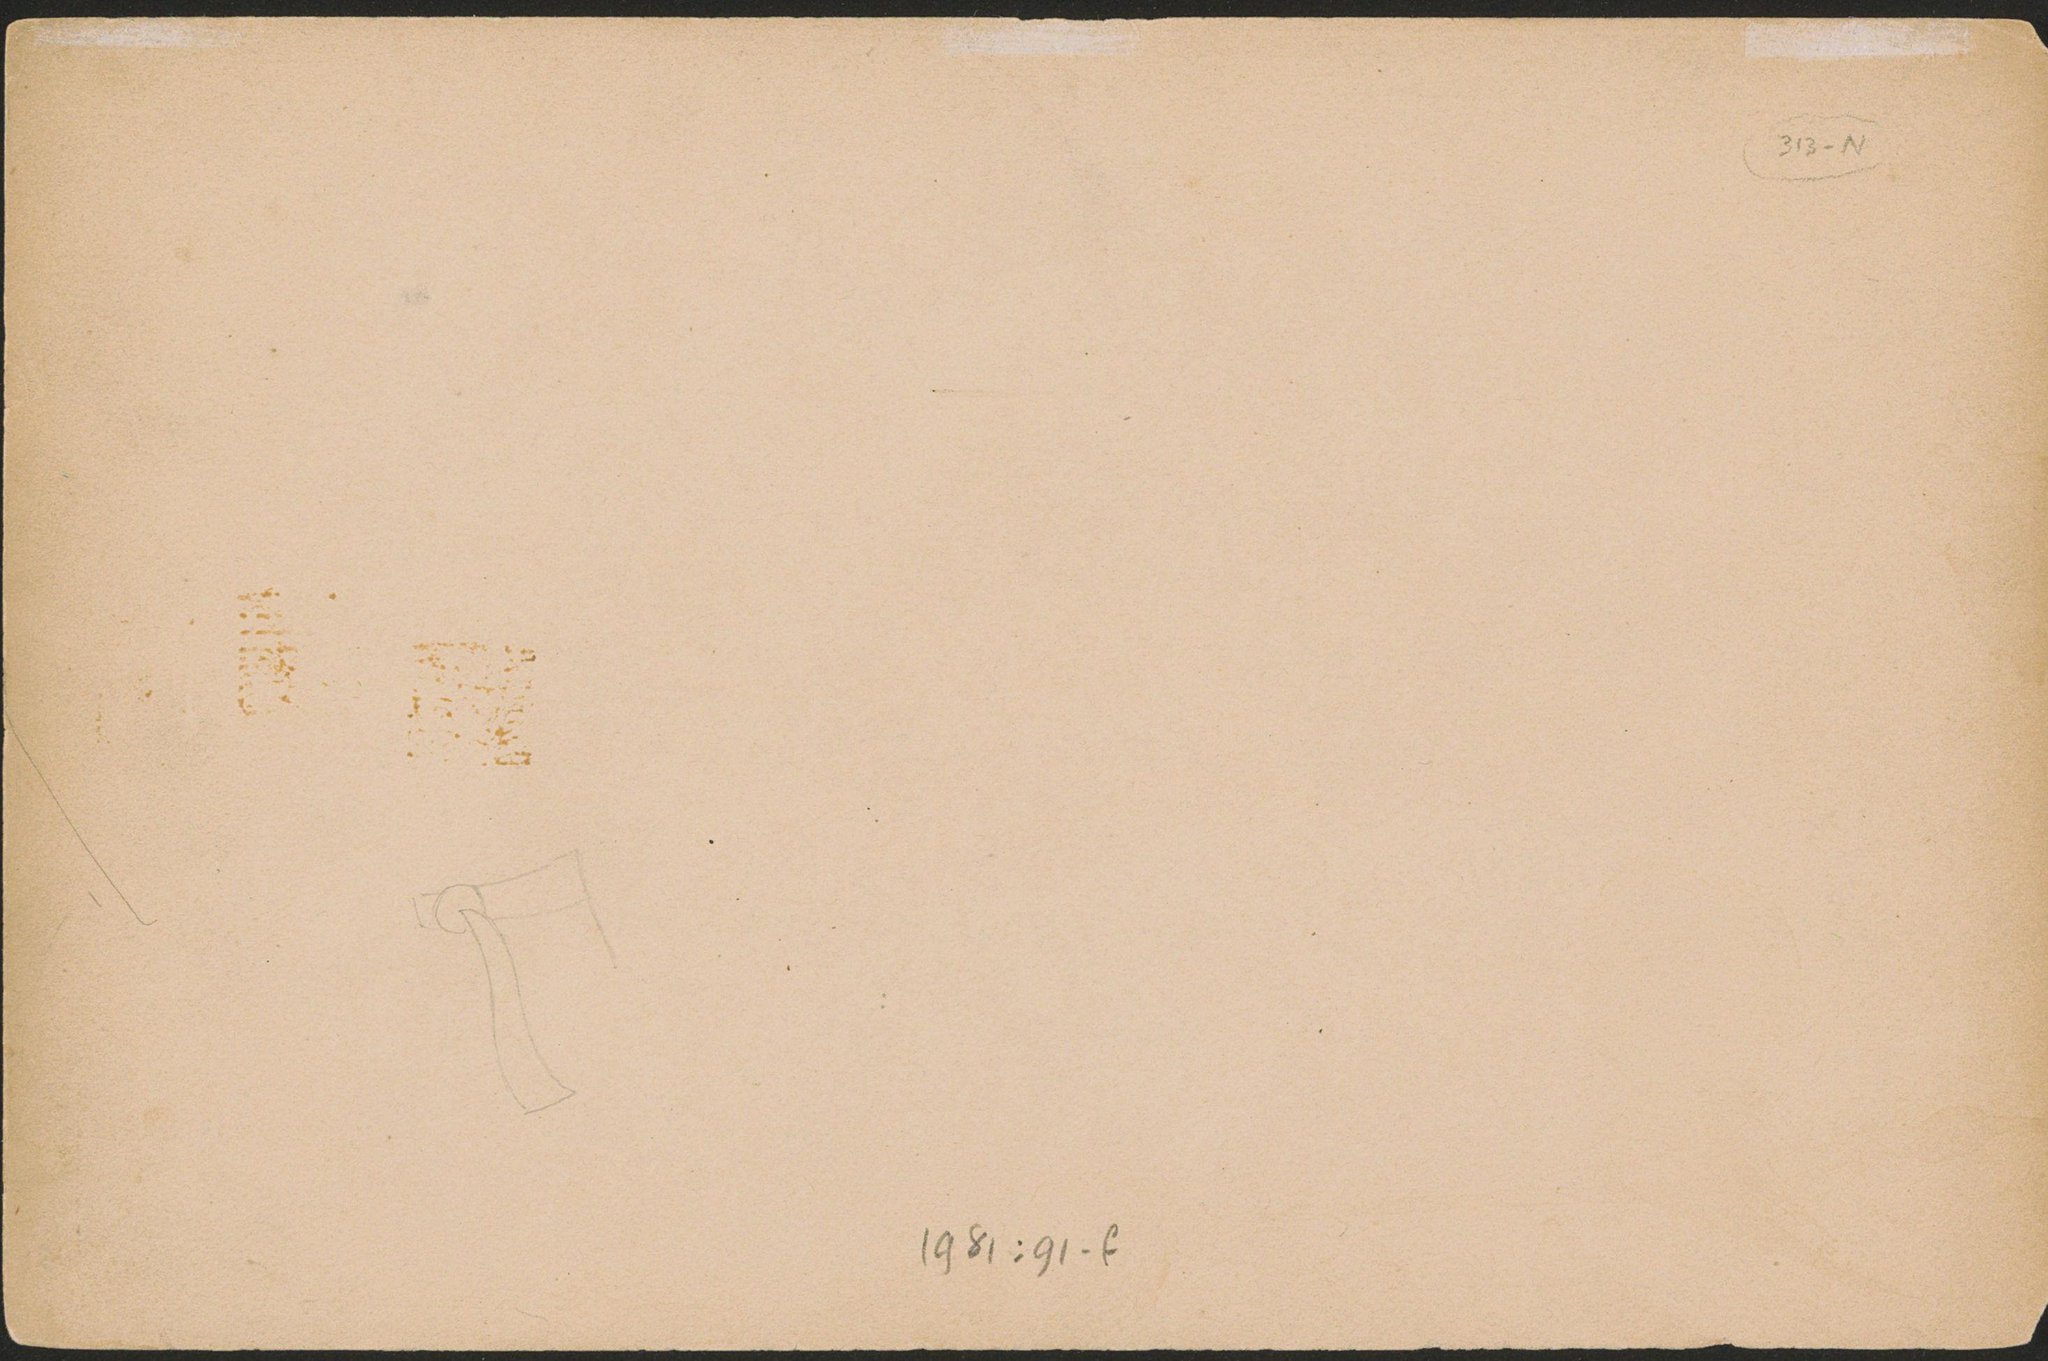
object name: sketchbook leaf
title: Studie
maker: willem de famars testas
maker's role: draughtsman, painter, print maker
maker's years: 1834-1896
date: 1859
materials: paper, pencil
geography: egypt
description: Mogelijk een stuk gereedschap. Verso-zijde van een los blad behorende bij een schetsboek met 23 bladen met schetsen gemaakt tijdens een reis door Egypte.